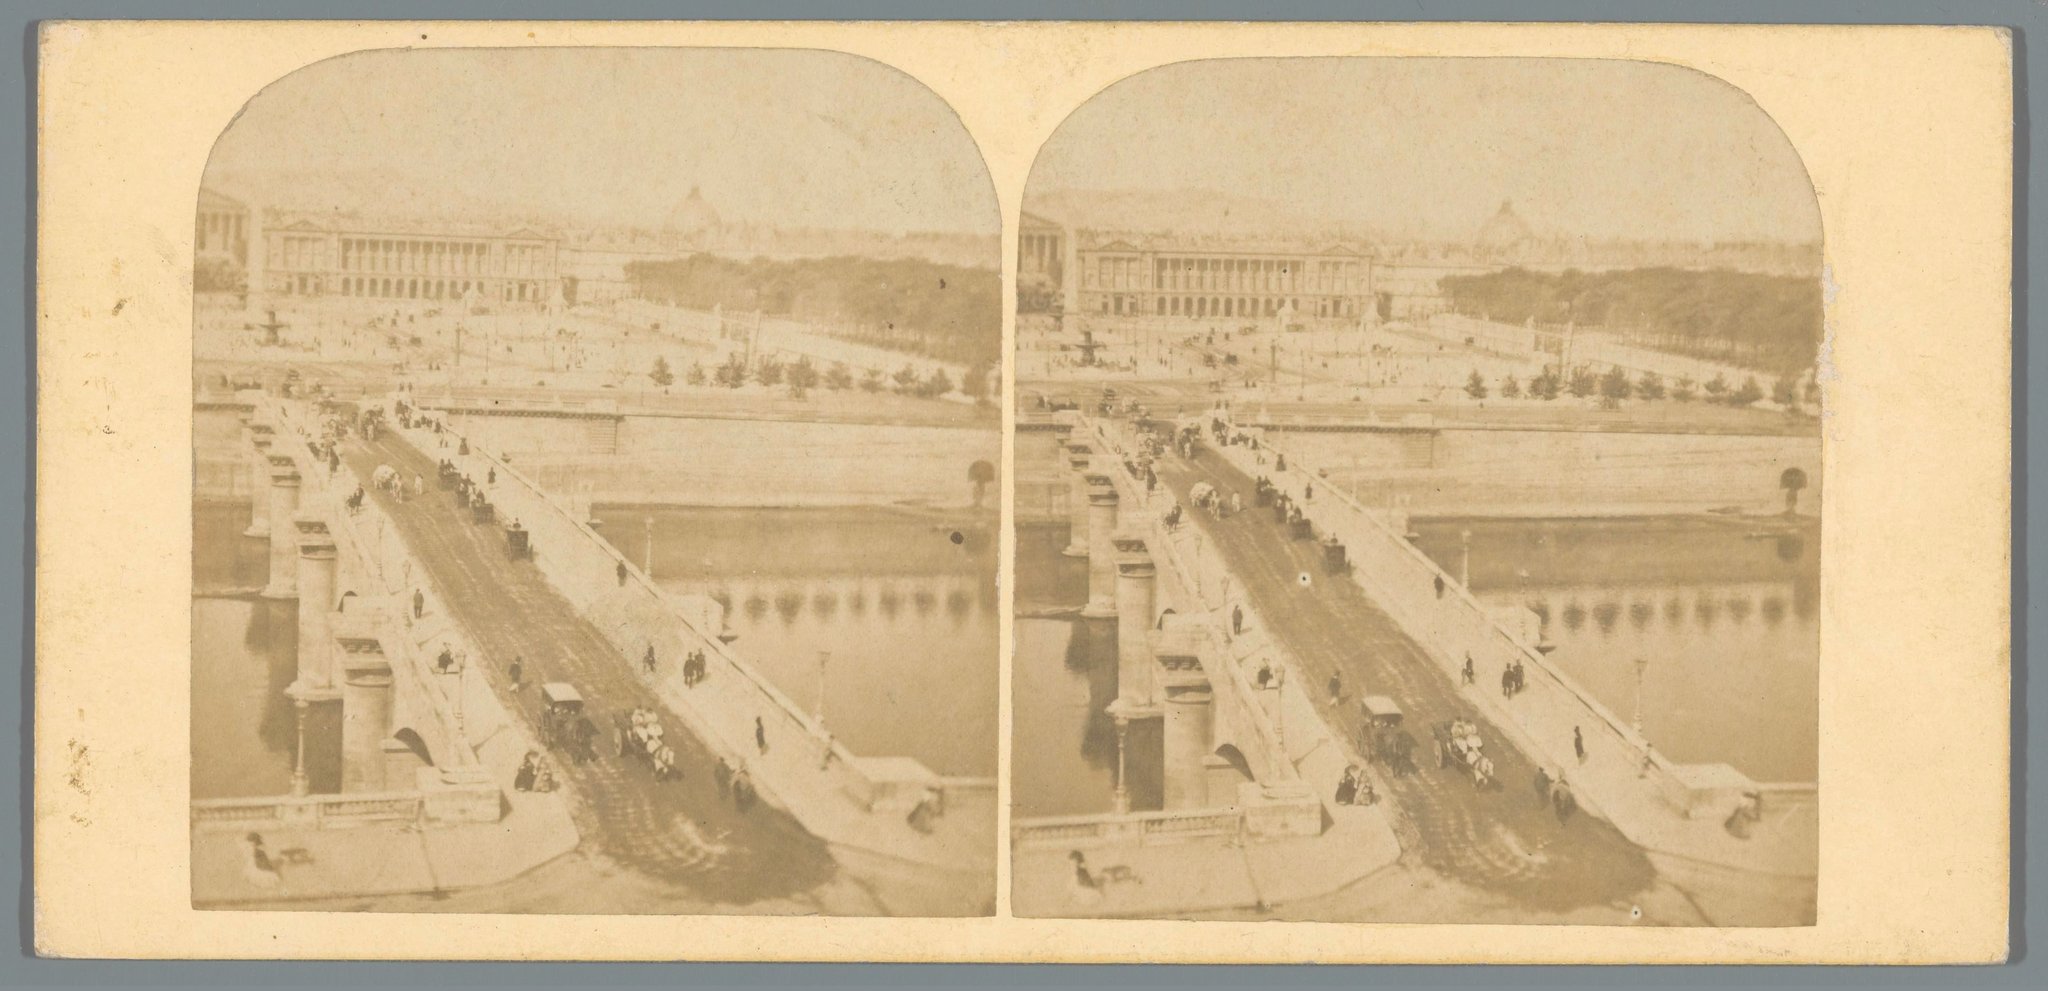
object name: stereograph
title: Gezicht op de Pont de la Concorde en Place de la Concorde in Parijs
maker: Anonymous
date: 1850-1880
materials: cardboard, photographic support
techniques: albumen print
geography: paris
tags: square, place, circus, etc., bridge in city across river, canal, etc.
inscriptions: number: ‘No. 64. XXV’, inscription: ‘Paris Place de la Concorde’